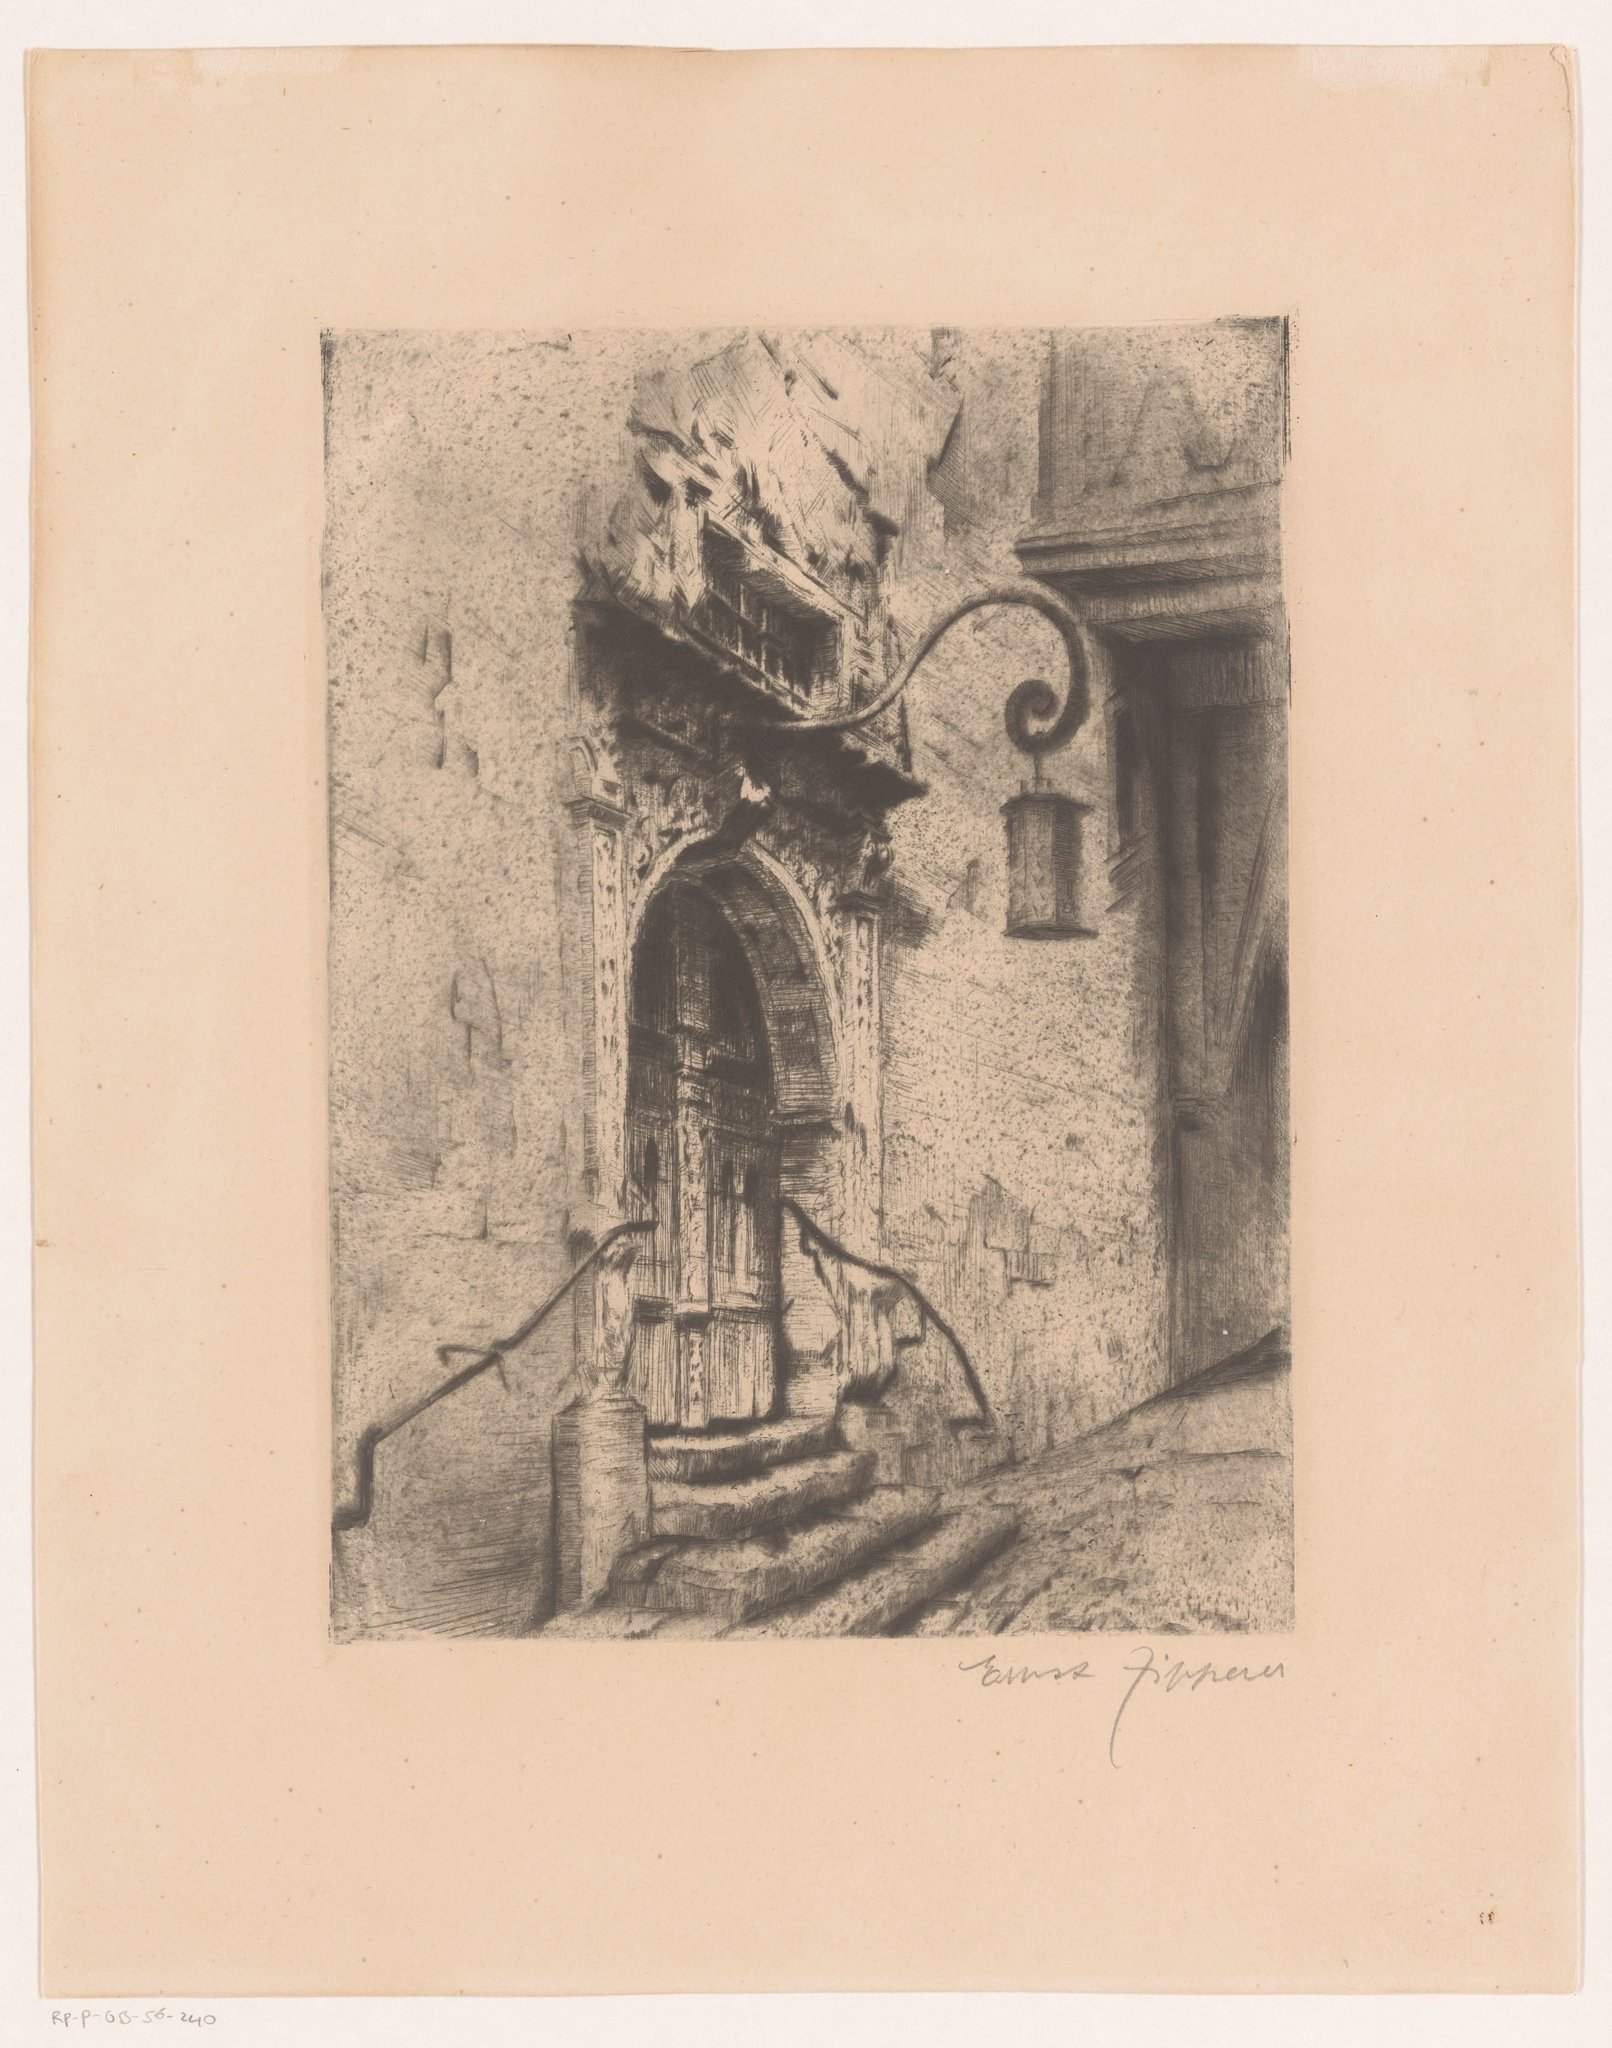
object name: print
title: Gezicht op een deur met een hangende lantaarn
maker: ernst zipperer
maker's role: print maker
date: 1800-1899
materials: paper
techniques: drypoint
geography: germany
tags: door, lantern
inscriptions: collector's mark: Lugt 2228